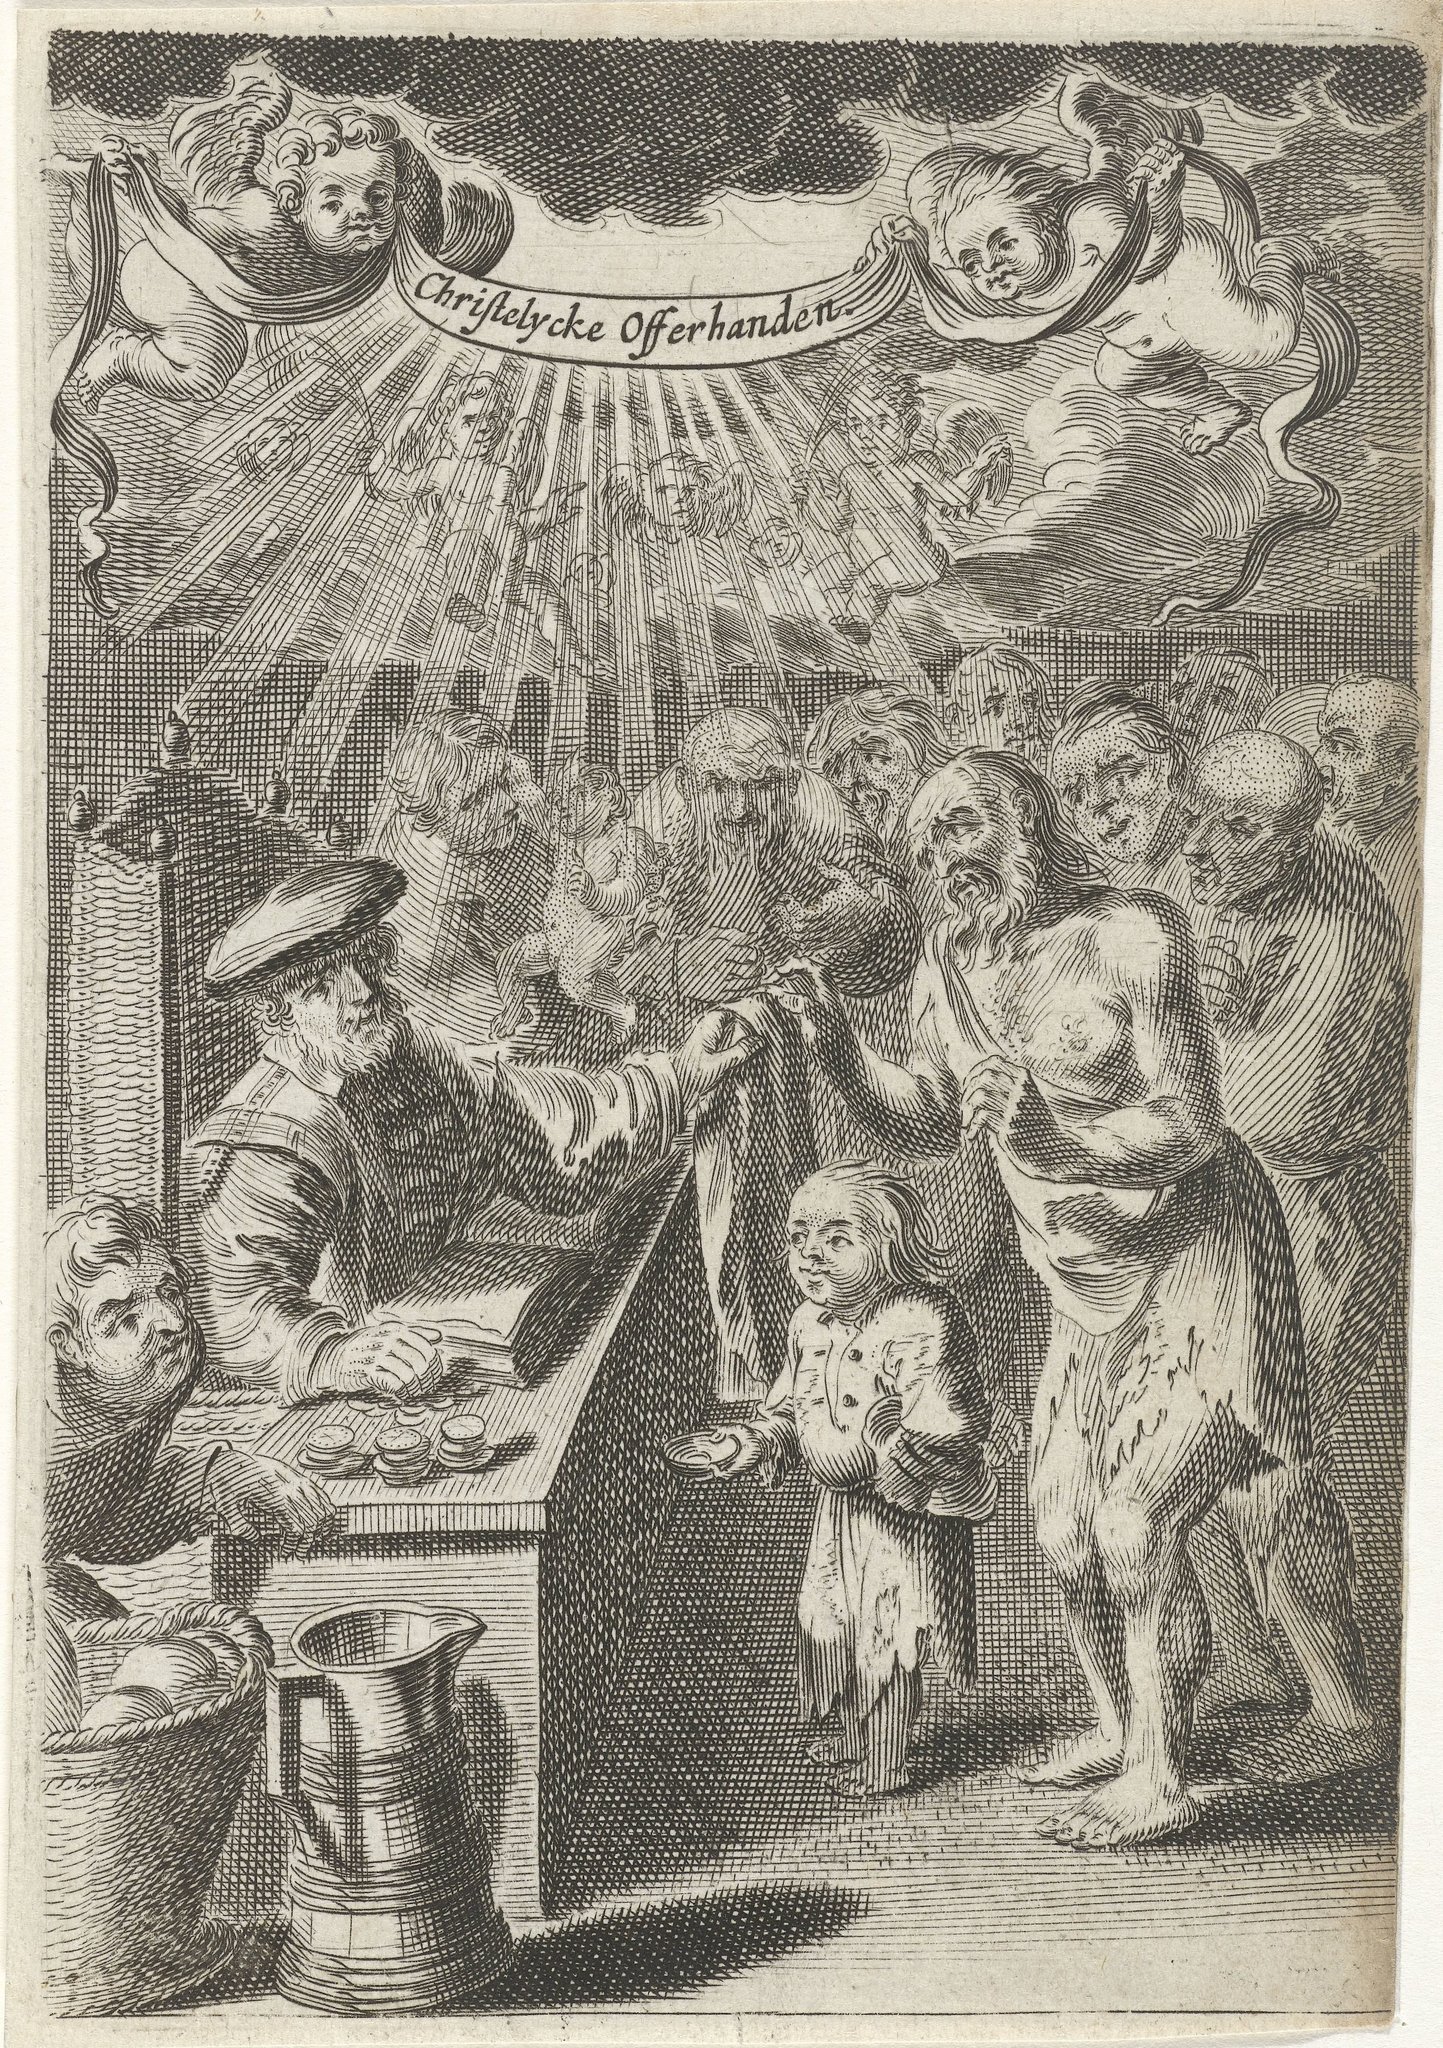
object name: titelblad, titelpagina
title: Titelpagina voor: Jan Hermansz Krul, Christelycke offerande, bestaende in gheestelĳcke rĳmen ende zangen, 1640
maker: pieter nolpe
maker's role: draughtsman, print maker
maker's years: 1613-1653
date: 1640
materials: paper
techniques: engraving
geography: amsterdam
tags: giving alms or other charity, e.g.: handing out food, the poor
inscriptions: collector's mark: Lugt 2228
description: Achter een toonbank staan twee mannen, die kleding, eten, drinken en geld uitdelen aan de armen. Twee putti tonen een banderol met de titel. Titelpagina voor het zangboek Christelycke offerande uit 1640. In de voorrede van het boek wordt de christelijke lezer opgeroepen zijn rijkdommen uit te delen aan de armen.